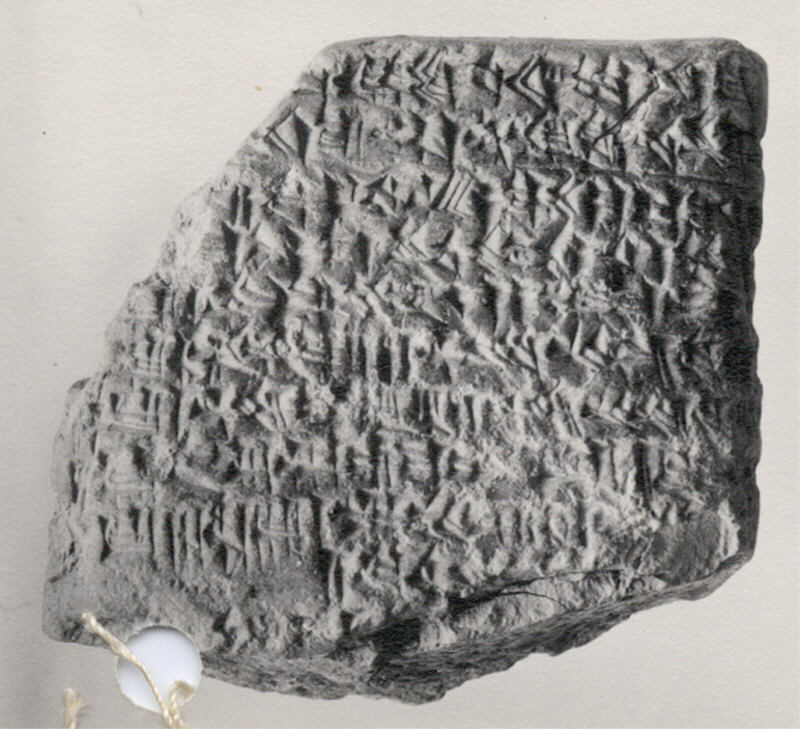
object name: cuneiform tablet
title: Cuneiform tablet impressed with seal: account of payments to hired workers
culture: achaemenid or babylonian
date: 700-301 BCE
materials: clay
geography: mesopotamia